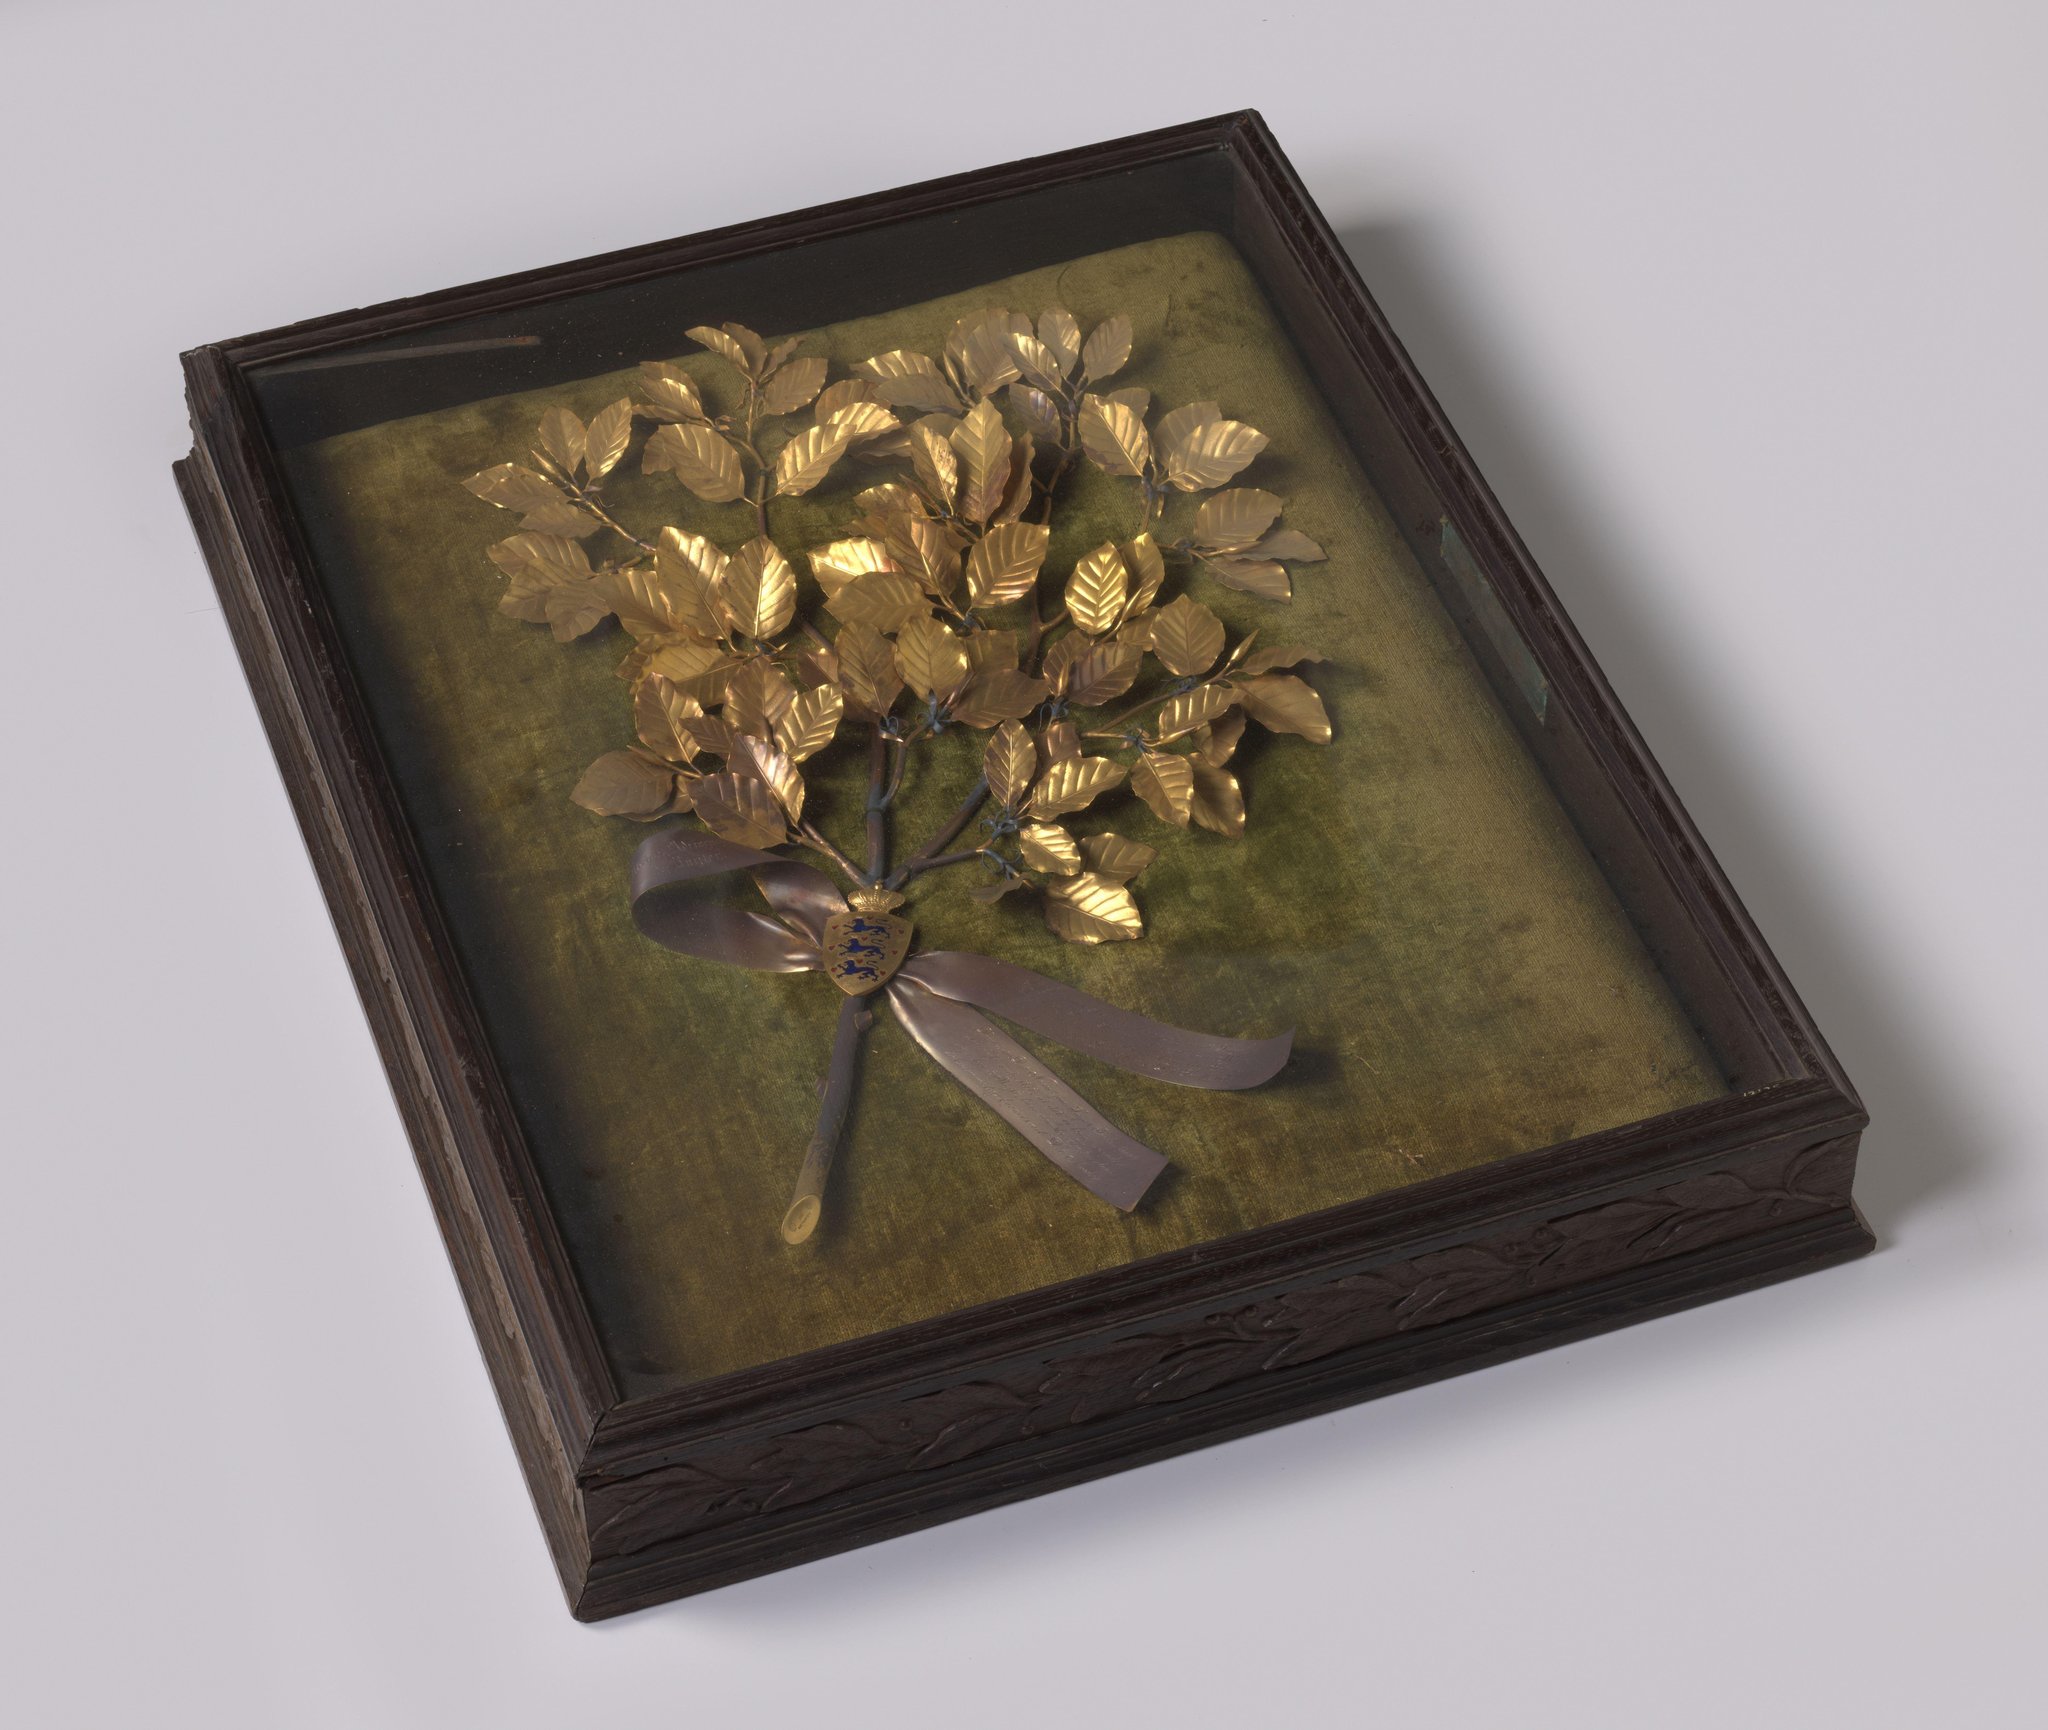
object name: chest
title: Gouden beuketak, op 23 maart 1907 als huldeblijk door Denemarken geplaatst op het praalgraf van Michiel Adriaenszoon de Ruyter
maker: aug. thomsen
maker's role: manufacturer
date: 1907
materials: brass, cardboard, copper, glass, leather, gold, velvet, wood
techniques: woodworking, casting, cutting, engraving, forging, gilding, soldering, stitching, striking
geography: denmark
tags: flushing, michiel adriaenszoon de ruyter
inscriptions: date